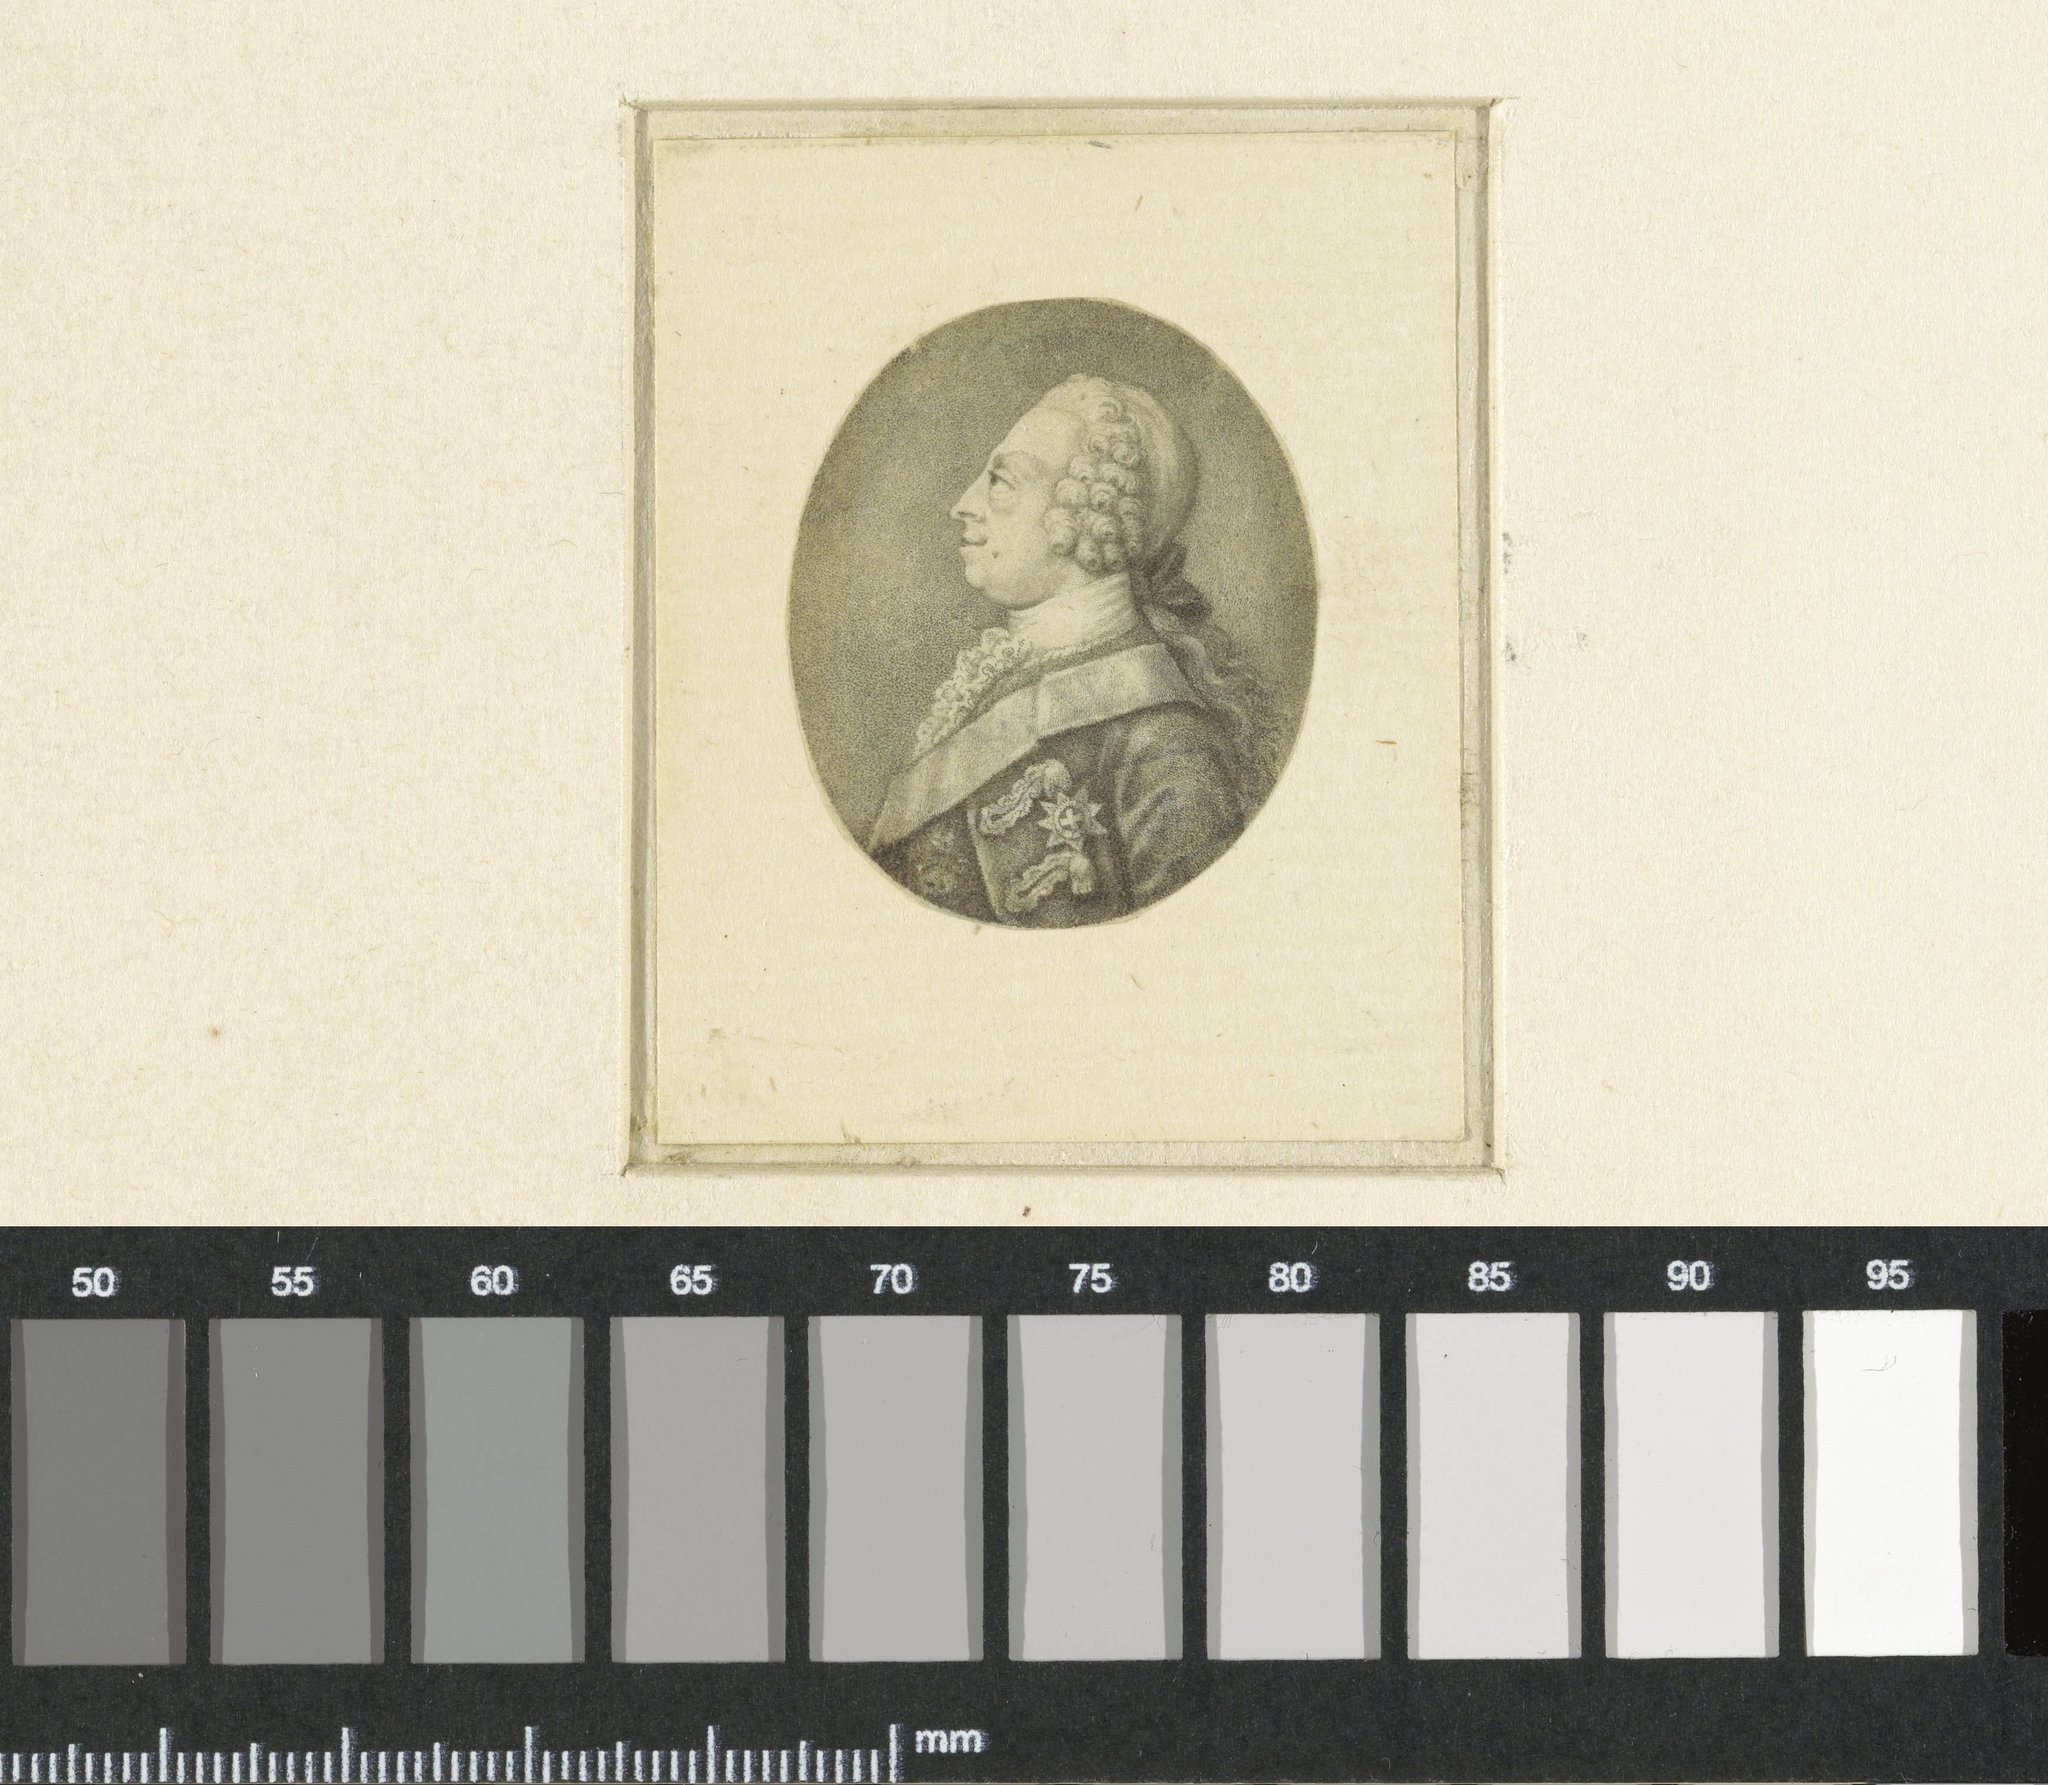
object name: drawing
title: Borstbeeld in ovaal van George III van Engeland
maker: Anonymous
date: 1760-1820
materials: ink, paper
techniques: pen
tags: london, george iii (koning van het verenigd koninkrijk)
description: Pendant van portret van Charlotte van Mecklenburg (inv. nr. RP-P-1910-1618). Coll. Verloren van Themaat. Geen prenten maar tek. liggen op Engels anon.